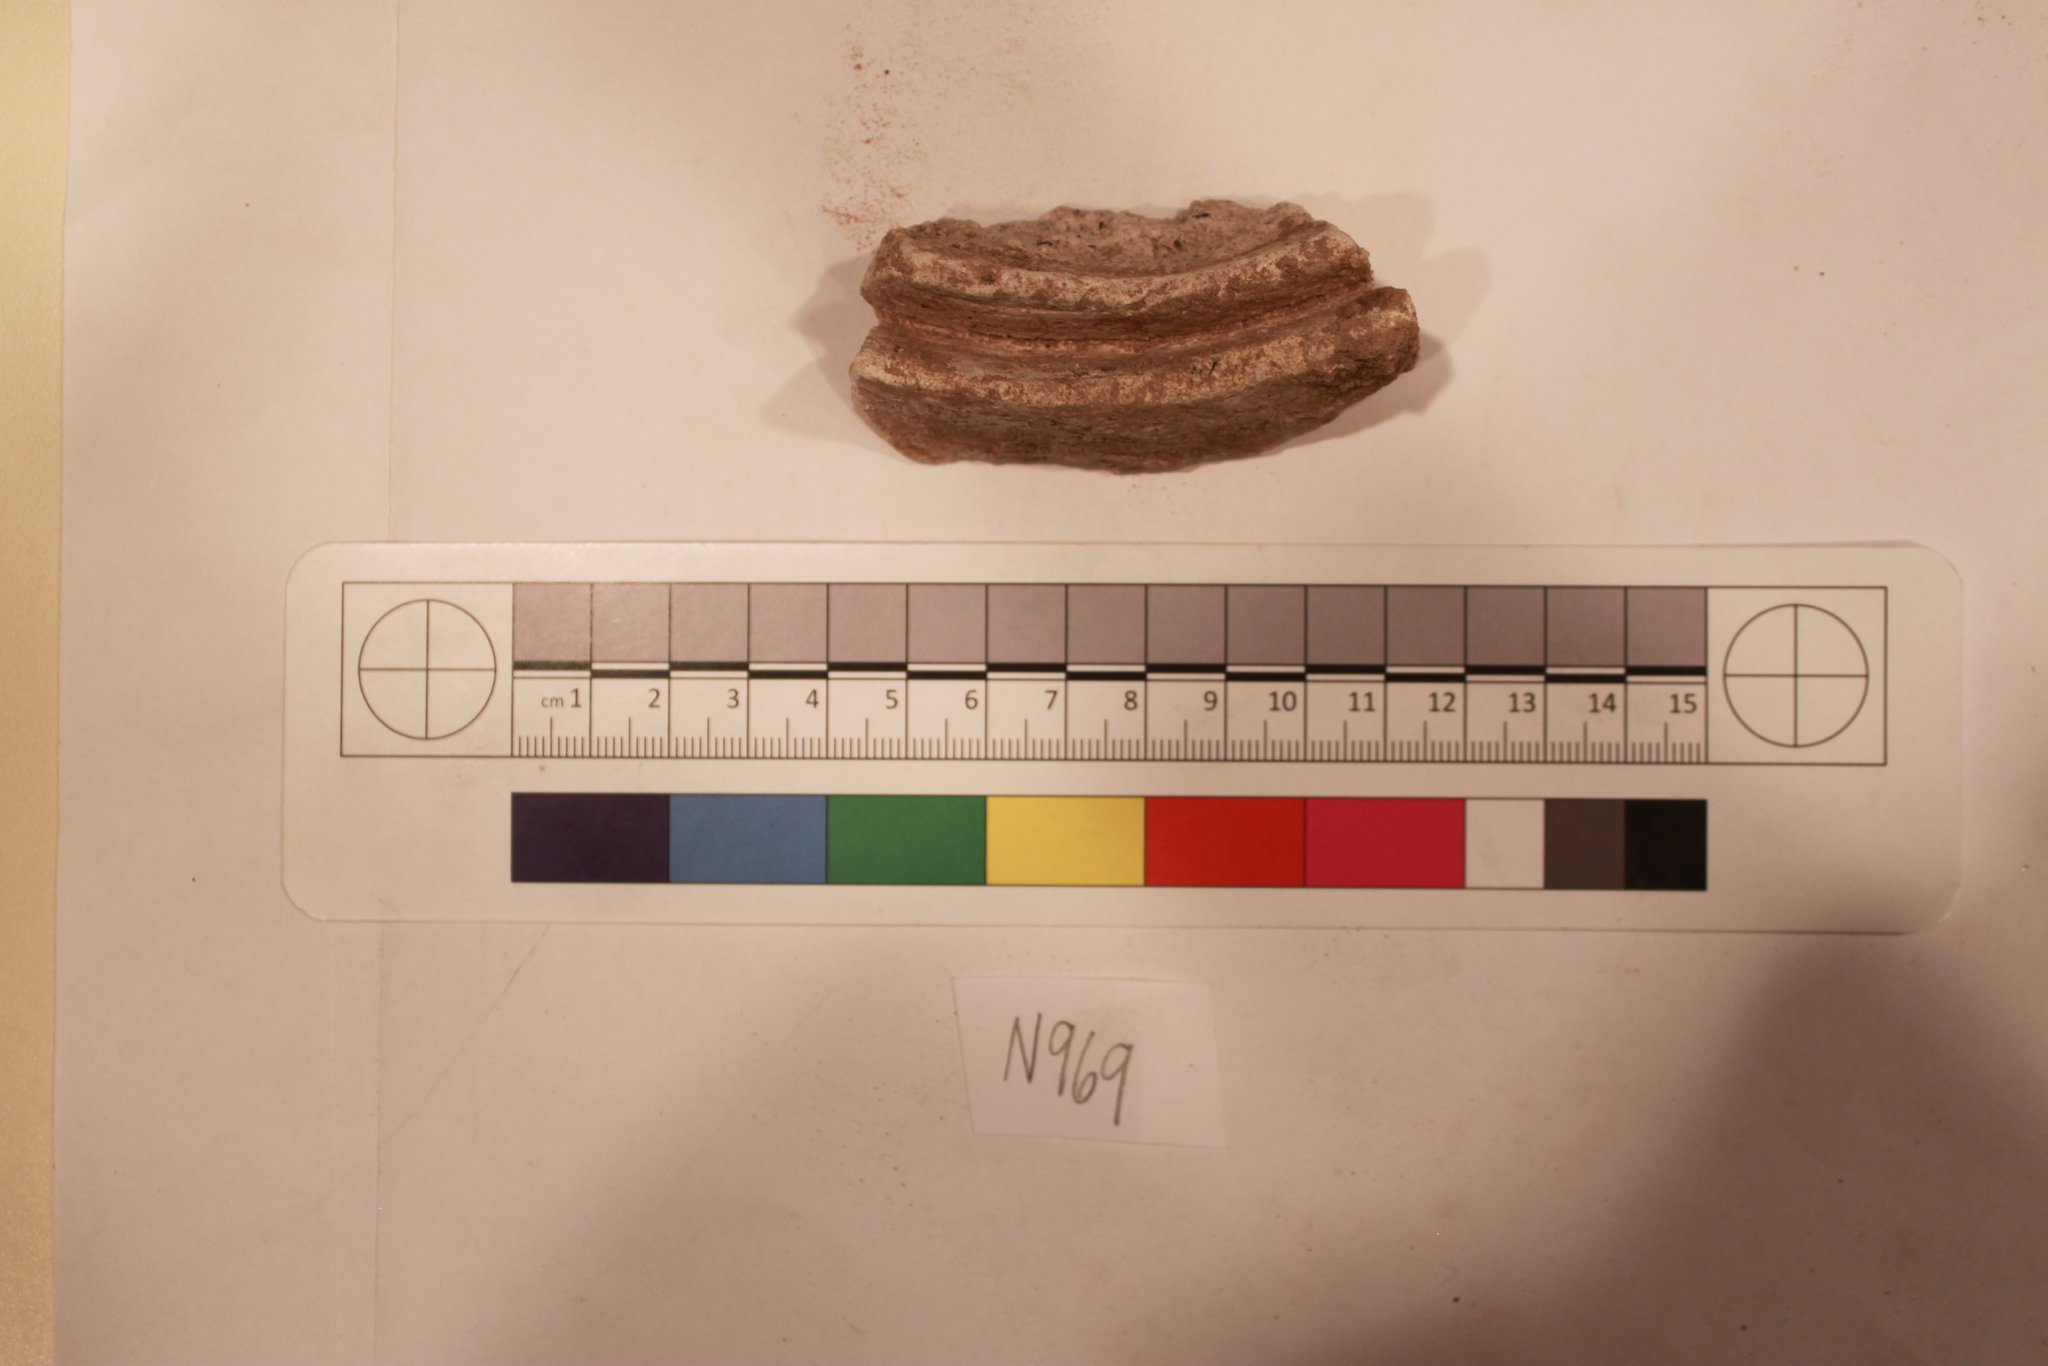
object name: fragment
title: Stucco Fragment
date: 701-1200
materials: plaster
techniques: carving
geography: iran